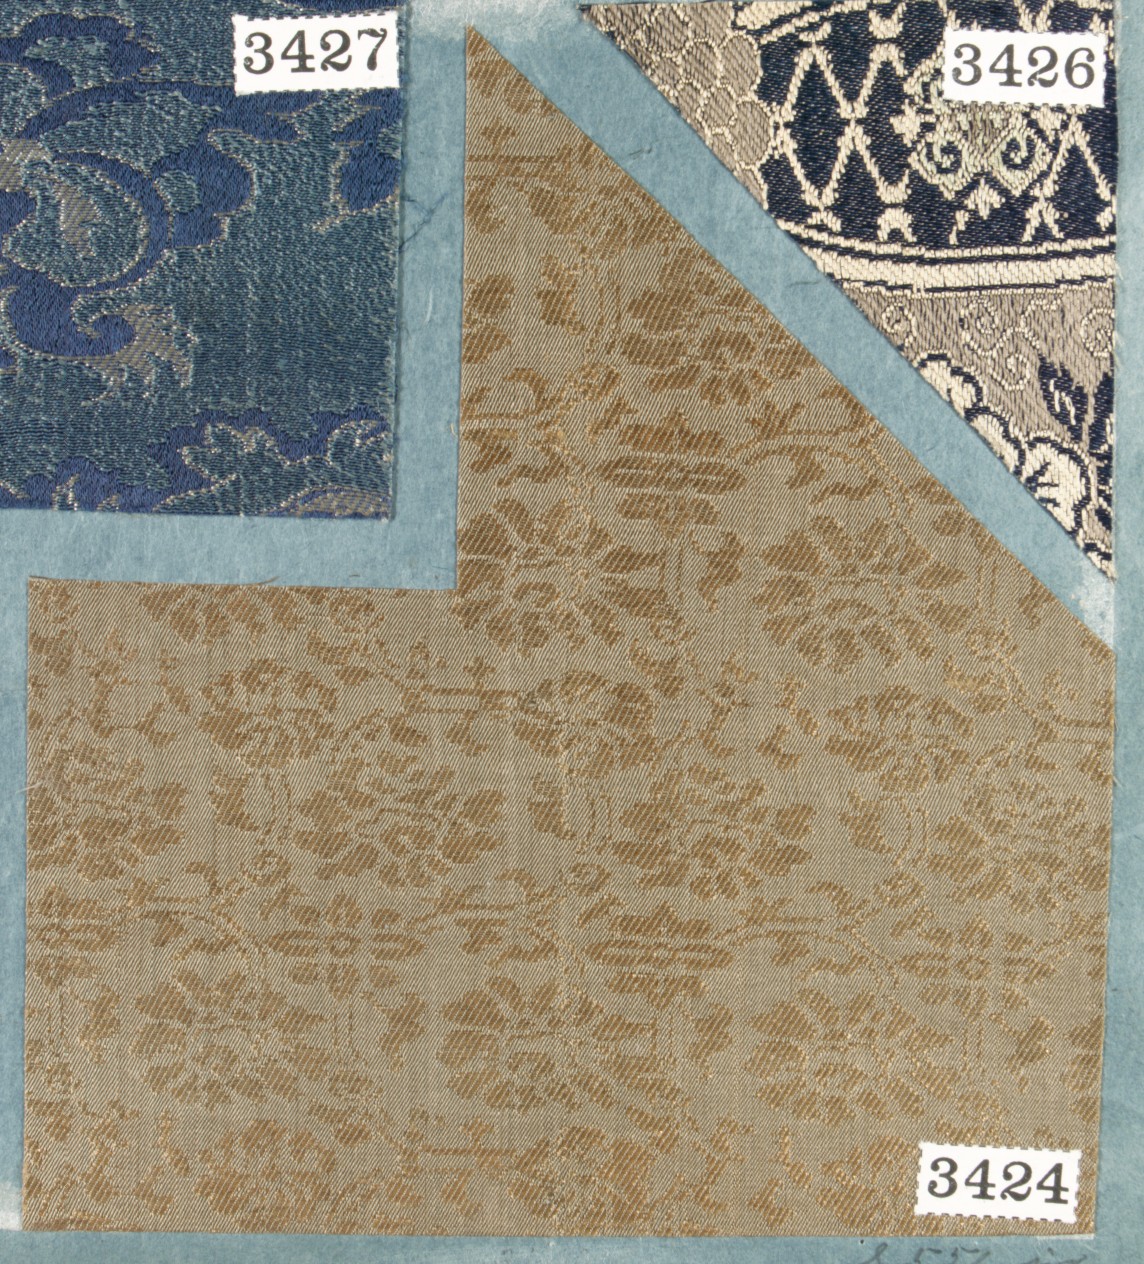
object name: textile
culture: japanese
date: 1801-1900